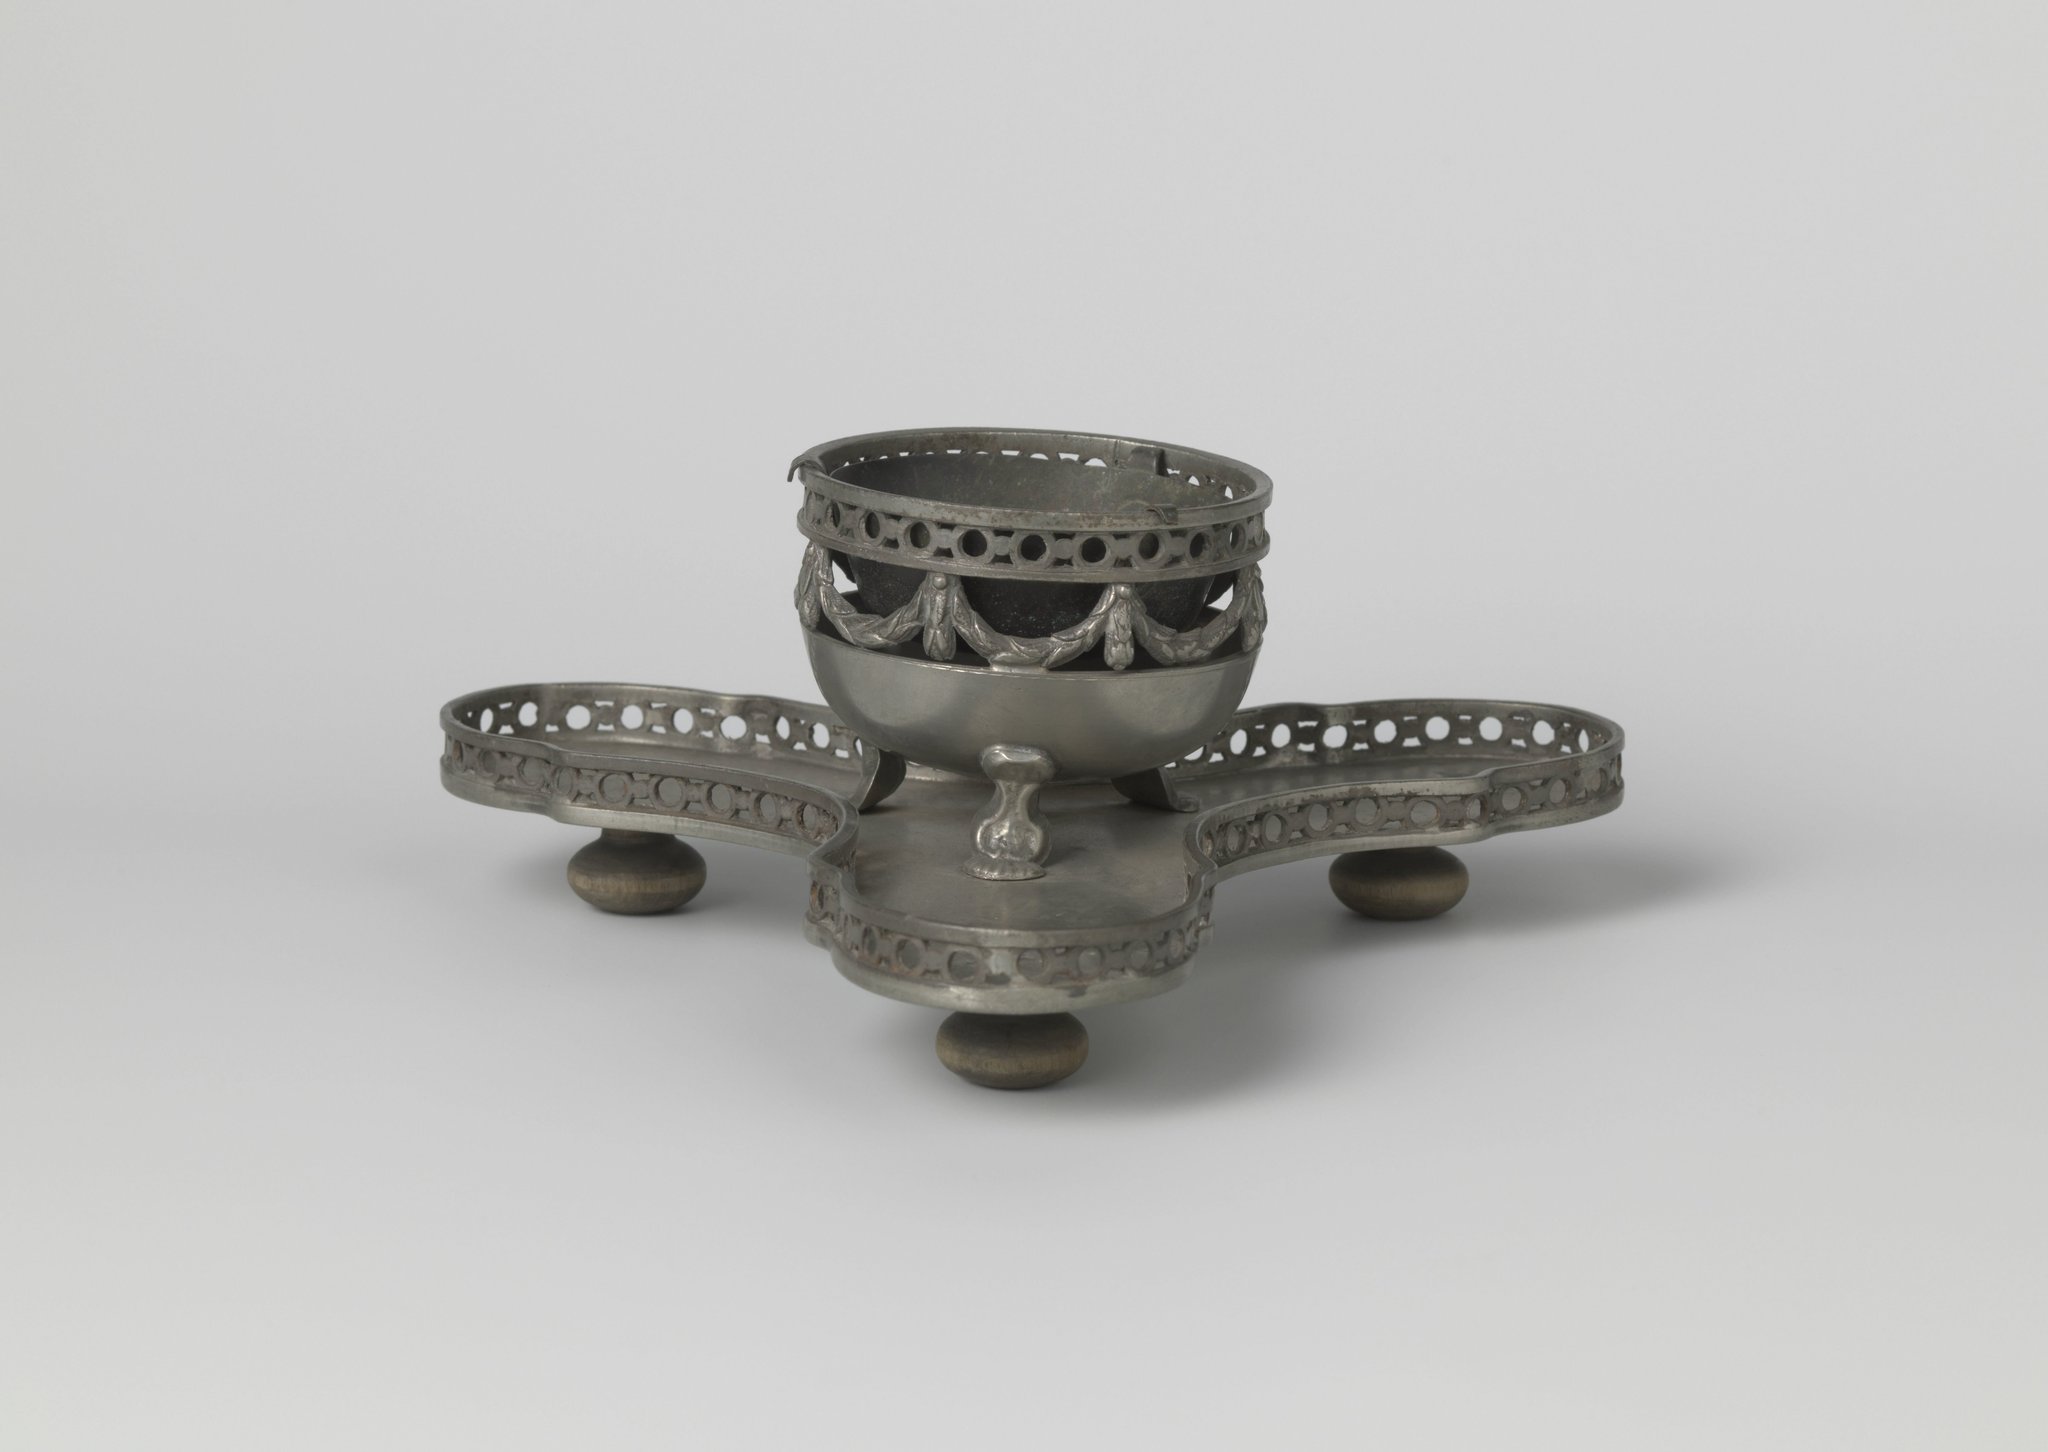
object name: onderstel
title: Onderstel van tin voor kraantjeskan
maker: carel lodewijk schurffius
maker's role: pewterers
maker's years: 1743-1812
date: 1775-1812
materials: copper, tin, wood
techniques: casting, turning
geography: netherlands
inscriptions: quality mark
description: Blad van tin dat dient als onderstel voor de kraantjeskan. Op de drie houten pootjes ligt een blad met een opstaande, opengewerkte band. Daar bovenop staat een komfoor op drie poten. De bovenrand van het comfoor is versierd met een opengewerkte band met guirlandes.